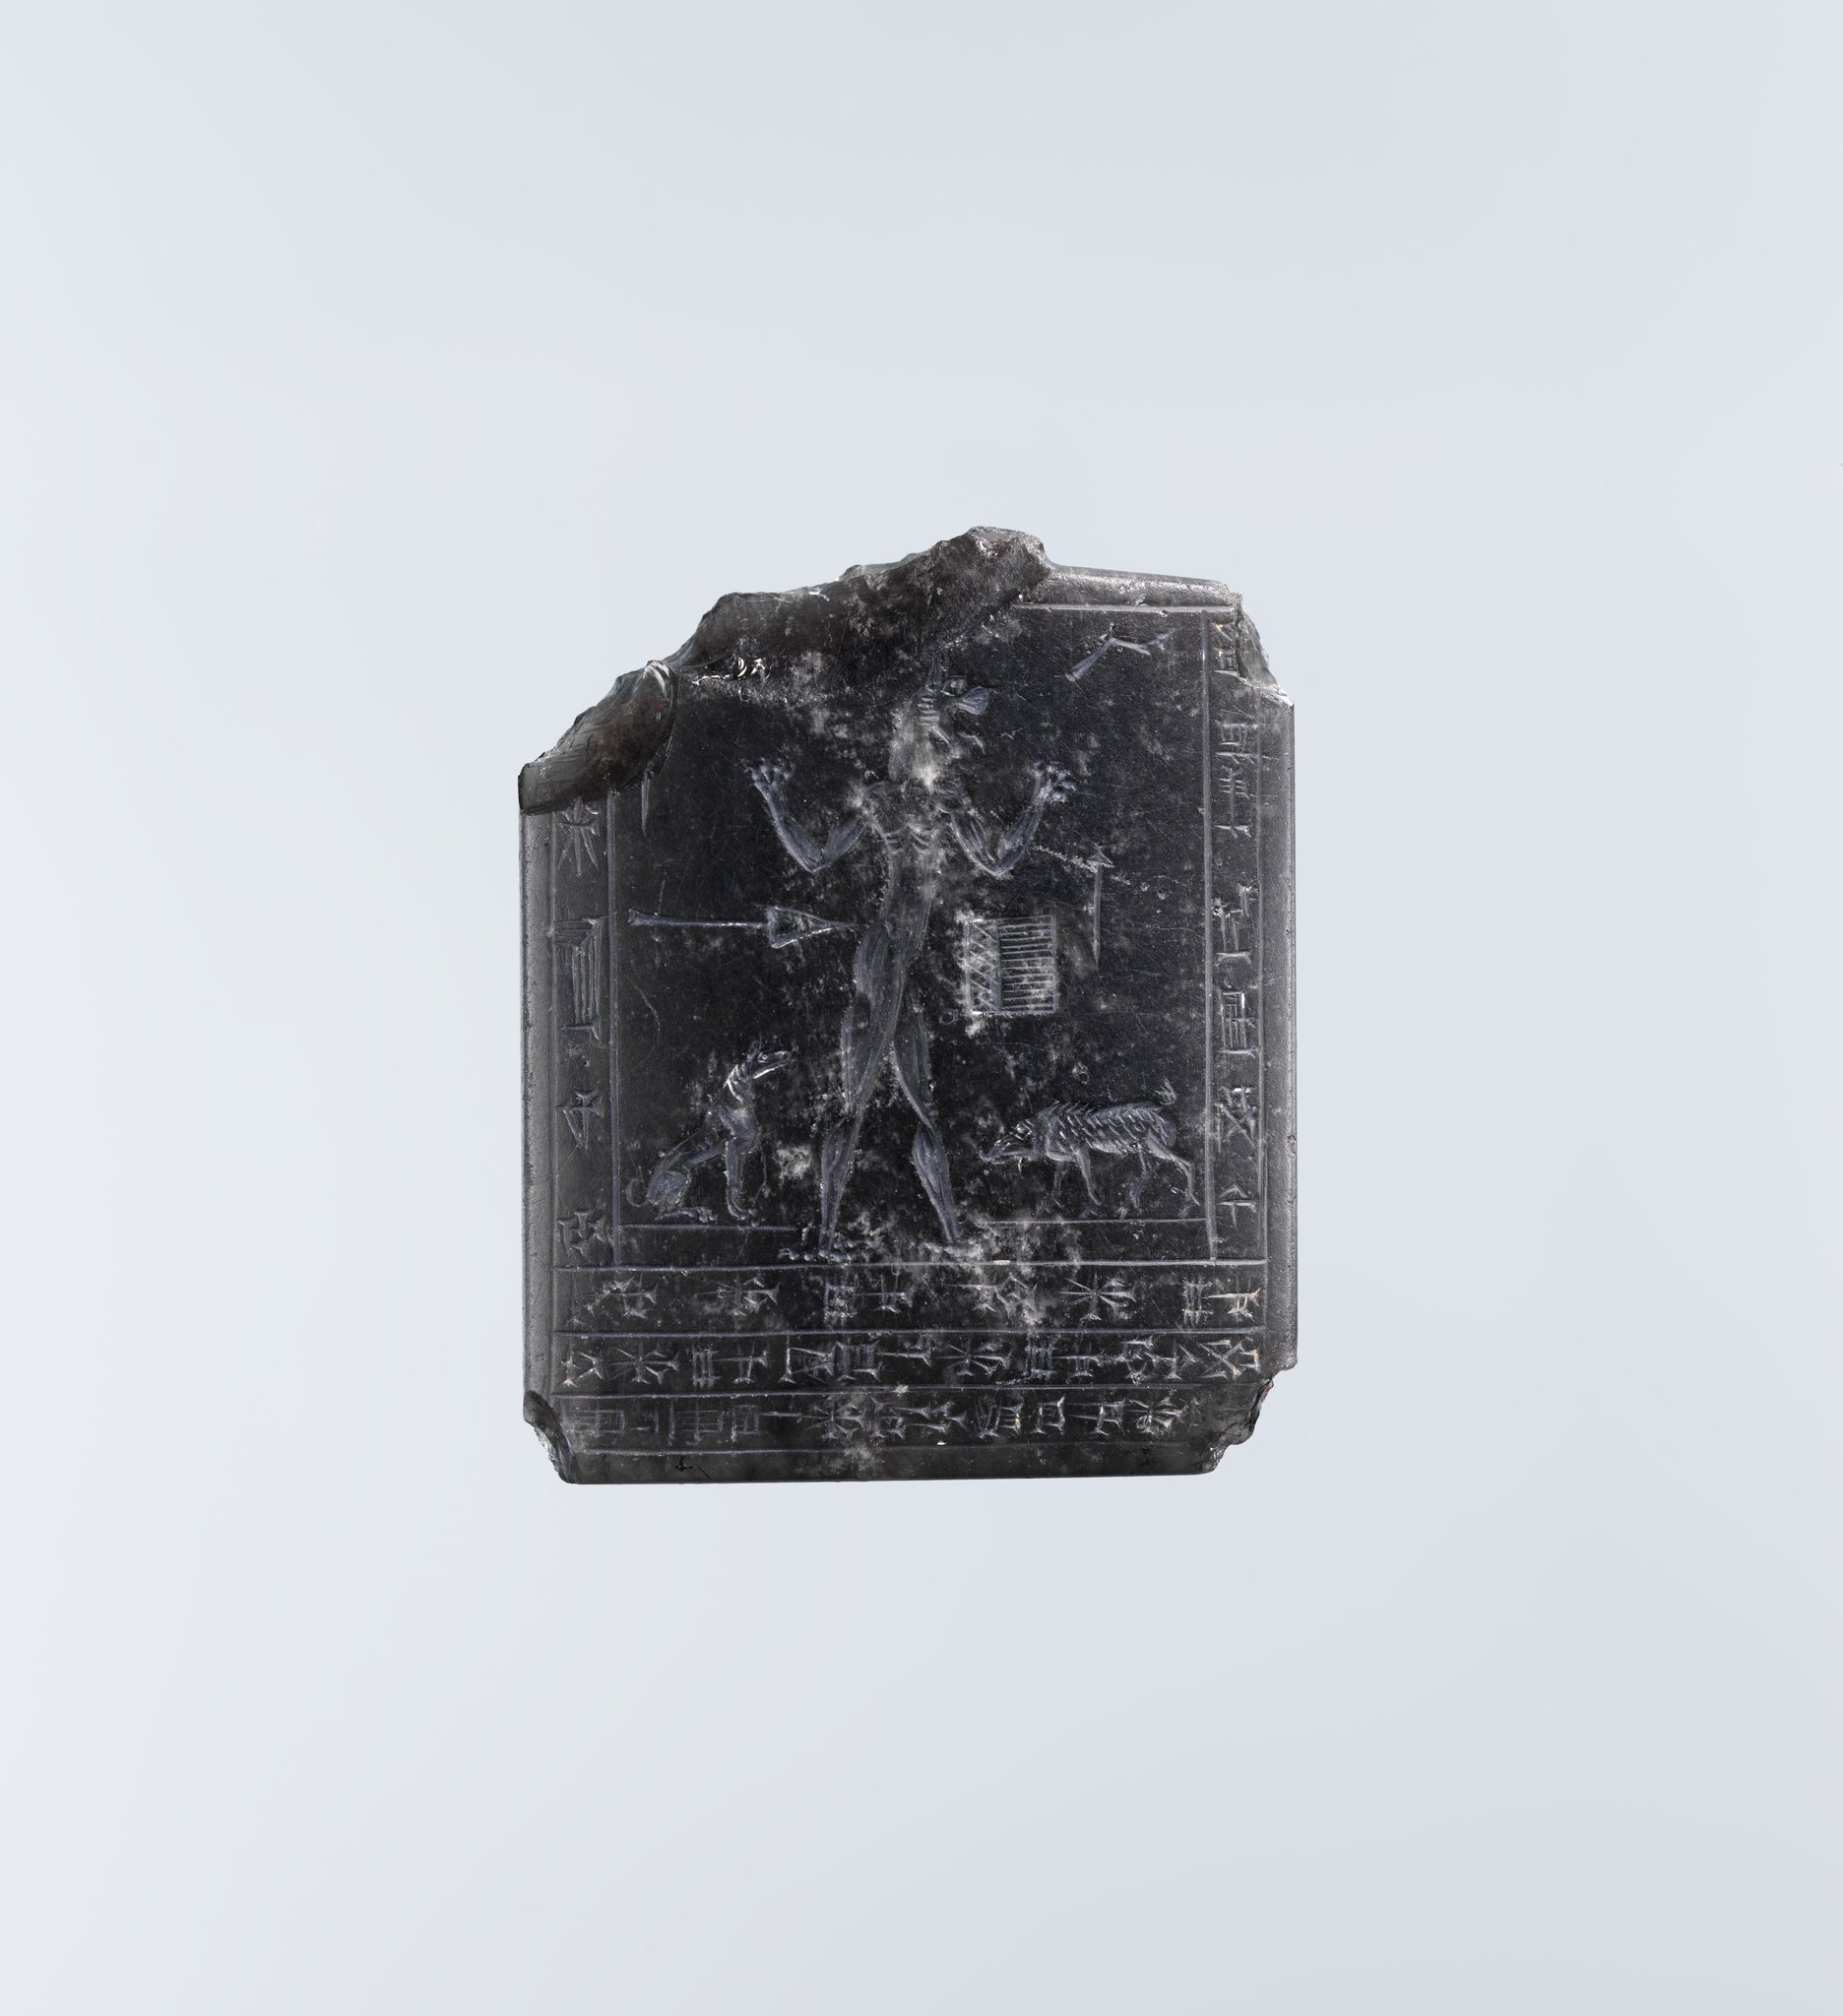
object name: necklace, bead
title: Amulet with a Lamashtu demon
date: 1000-668 BCE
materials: obsidian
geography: mesopotamia or iran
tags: arrows,boars,dogs,demons